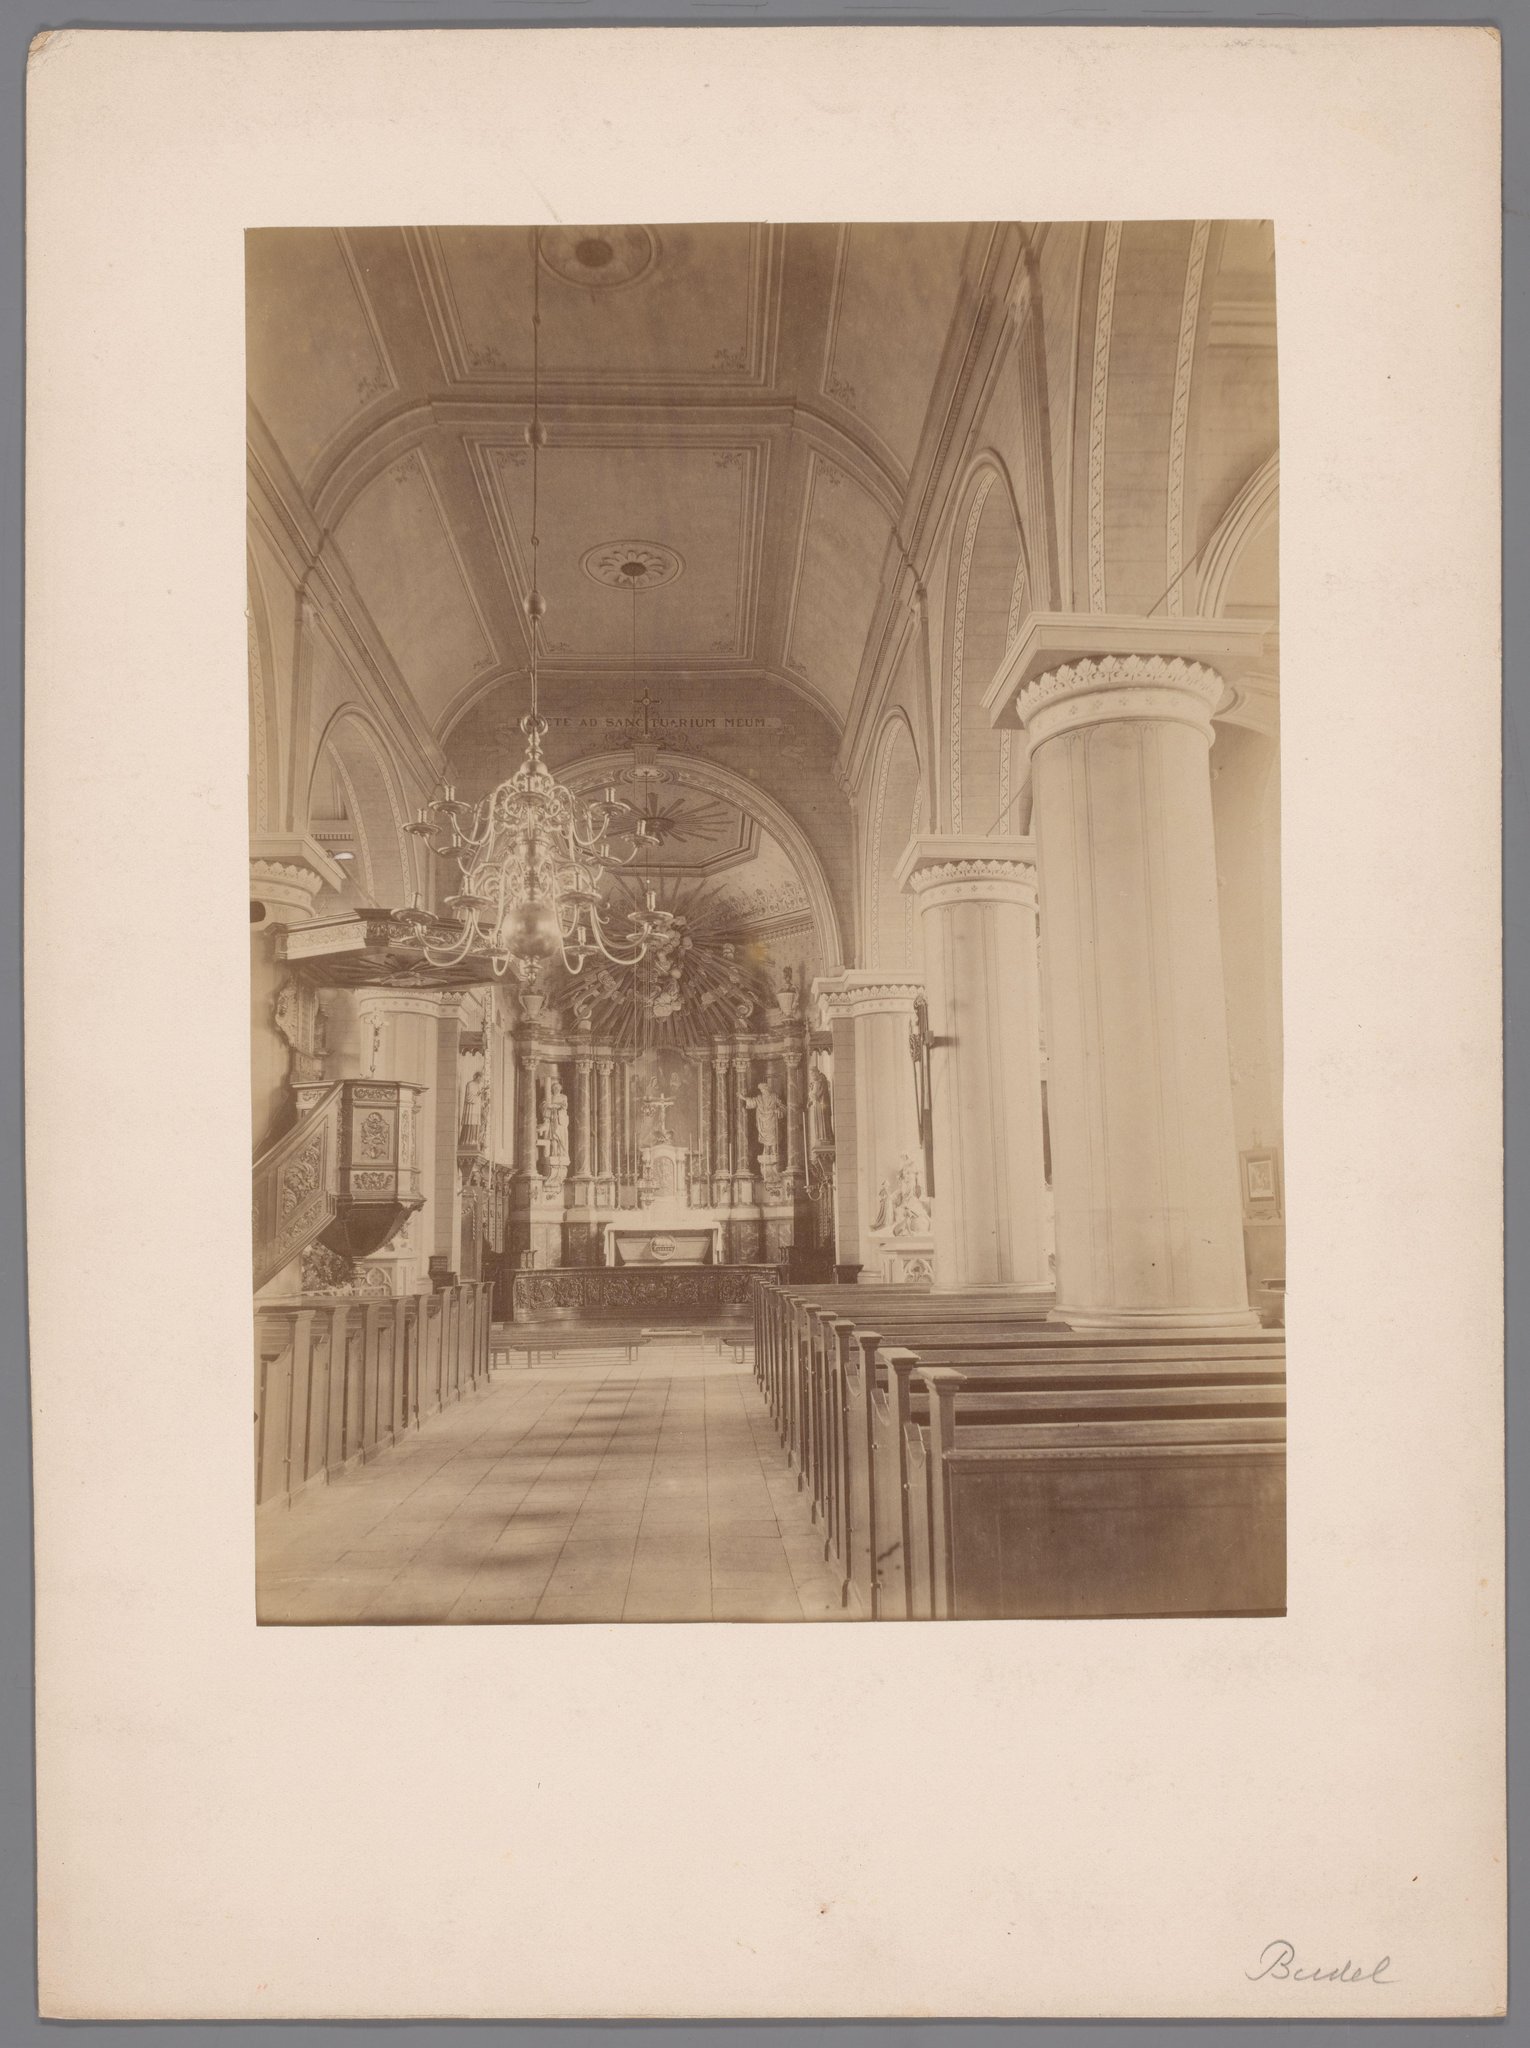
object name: photograph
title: Interieur van de Oude Onze-Lieve-Vrouw Visitatiekerk te Budel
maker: anoniem (monumentenzorg)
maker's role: fotograaf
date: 1902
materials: cardboard, photographic support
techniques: albumen print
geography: budel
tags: interior of church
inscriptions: annotation: ‘Budel’, annotation: ‘Budel (N.B.)/ Interieur der R.K. Kerk/ Mei 1902’